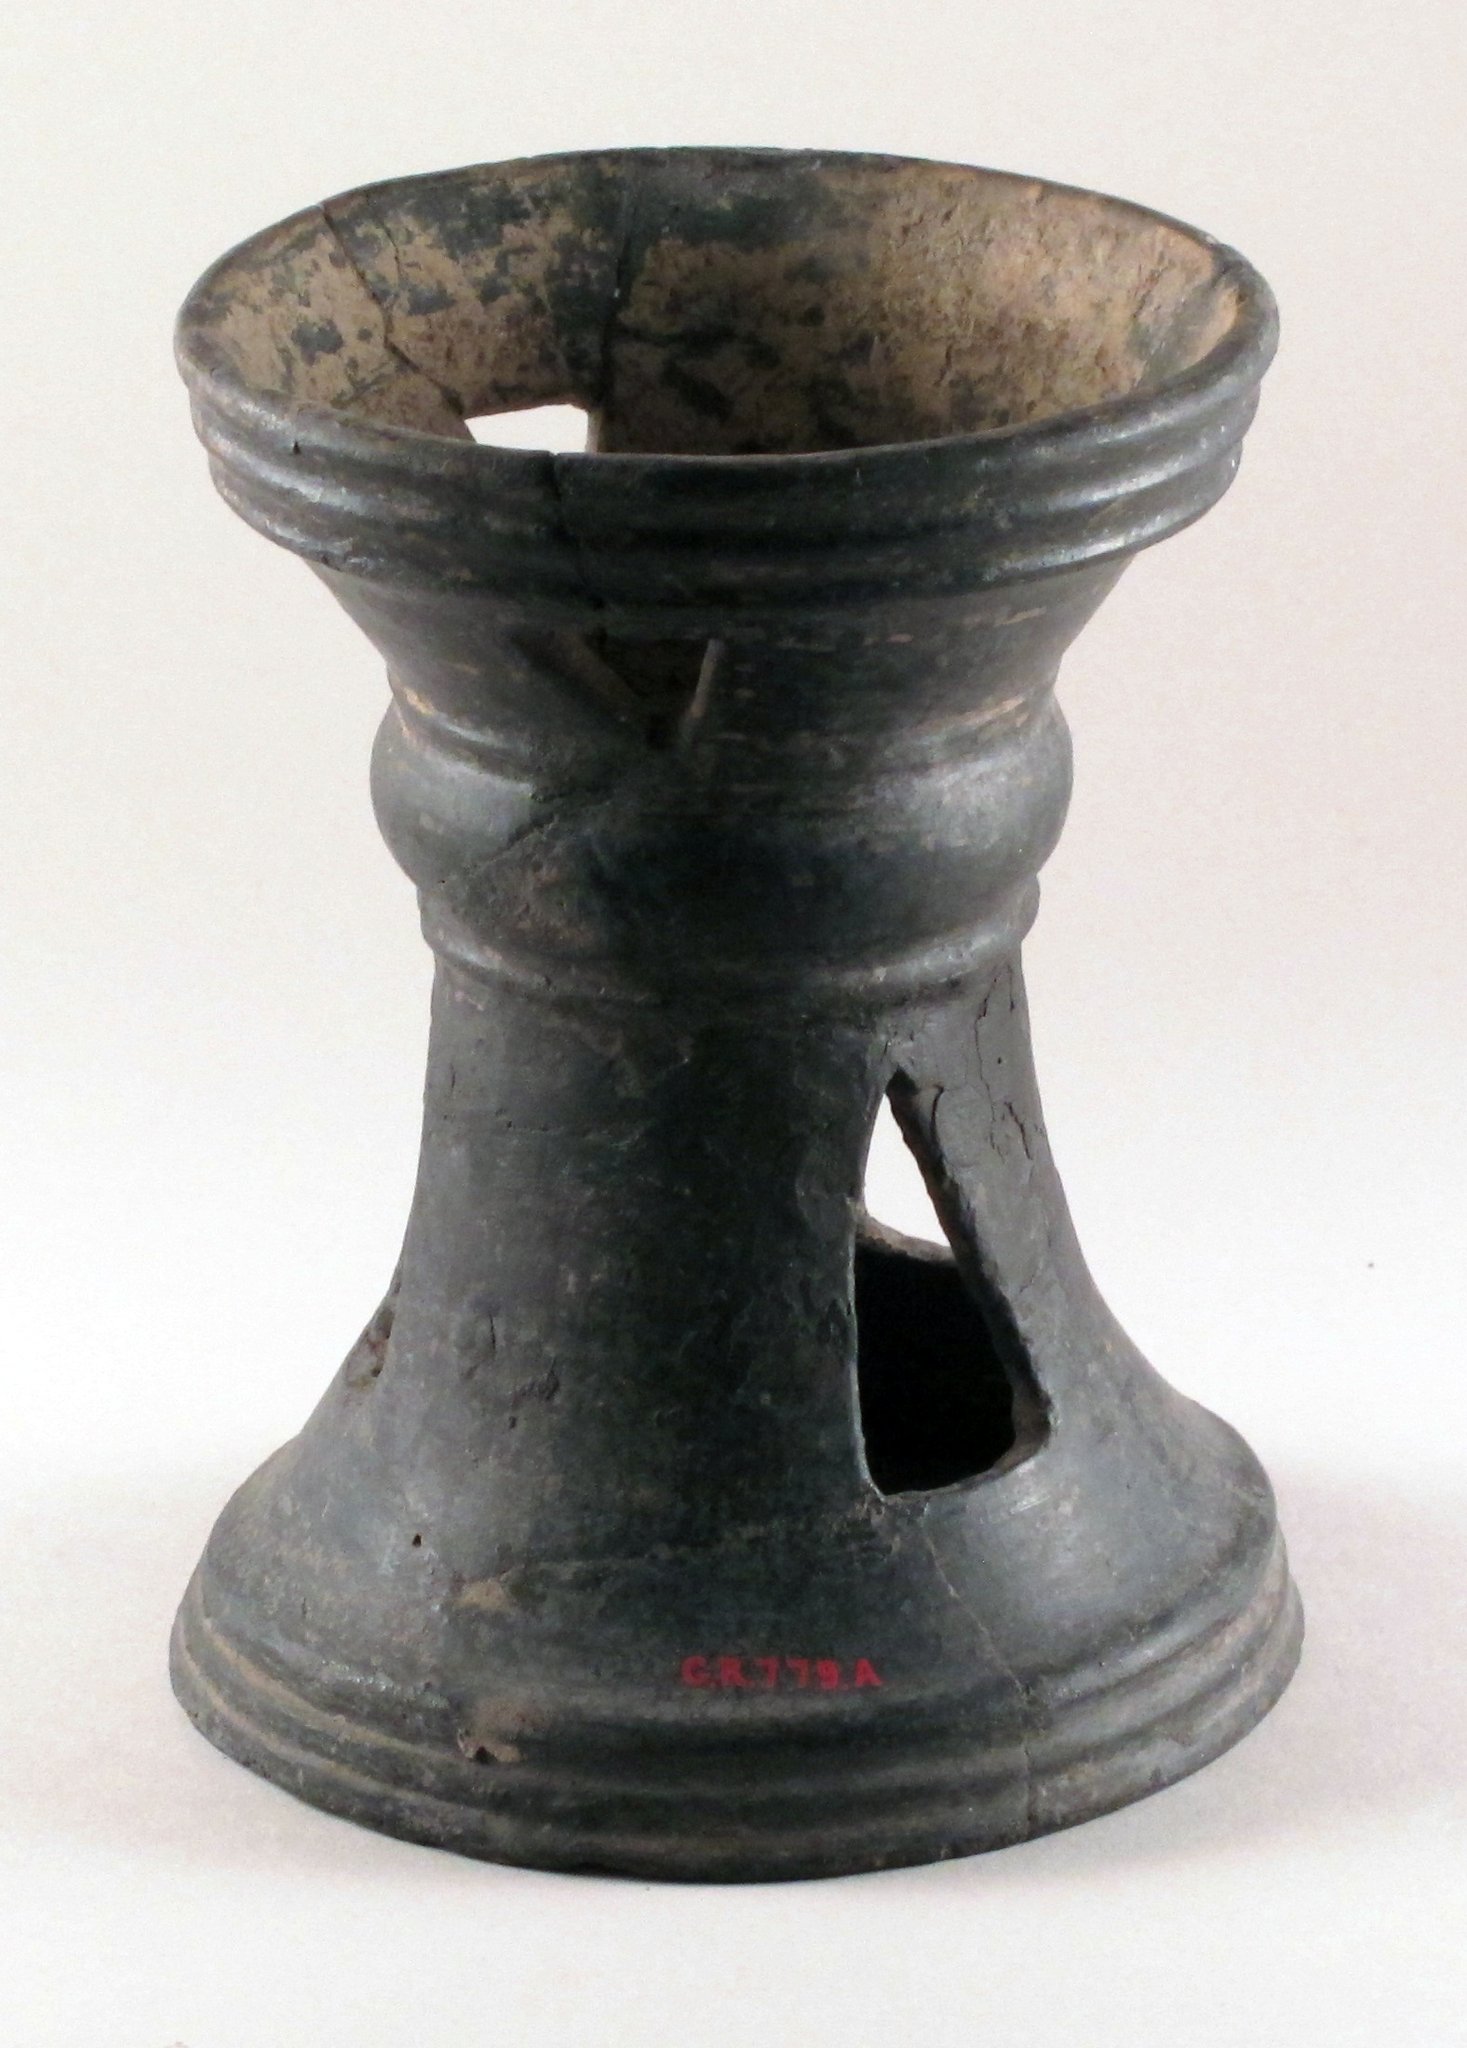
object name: dish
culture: etruscan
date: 550-500 BCE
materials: terracotta